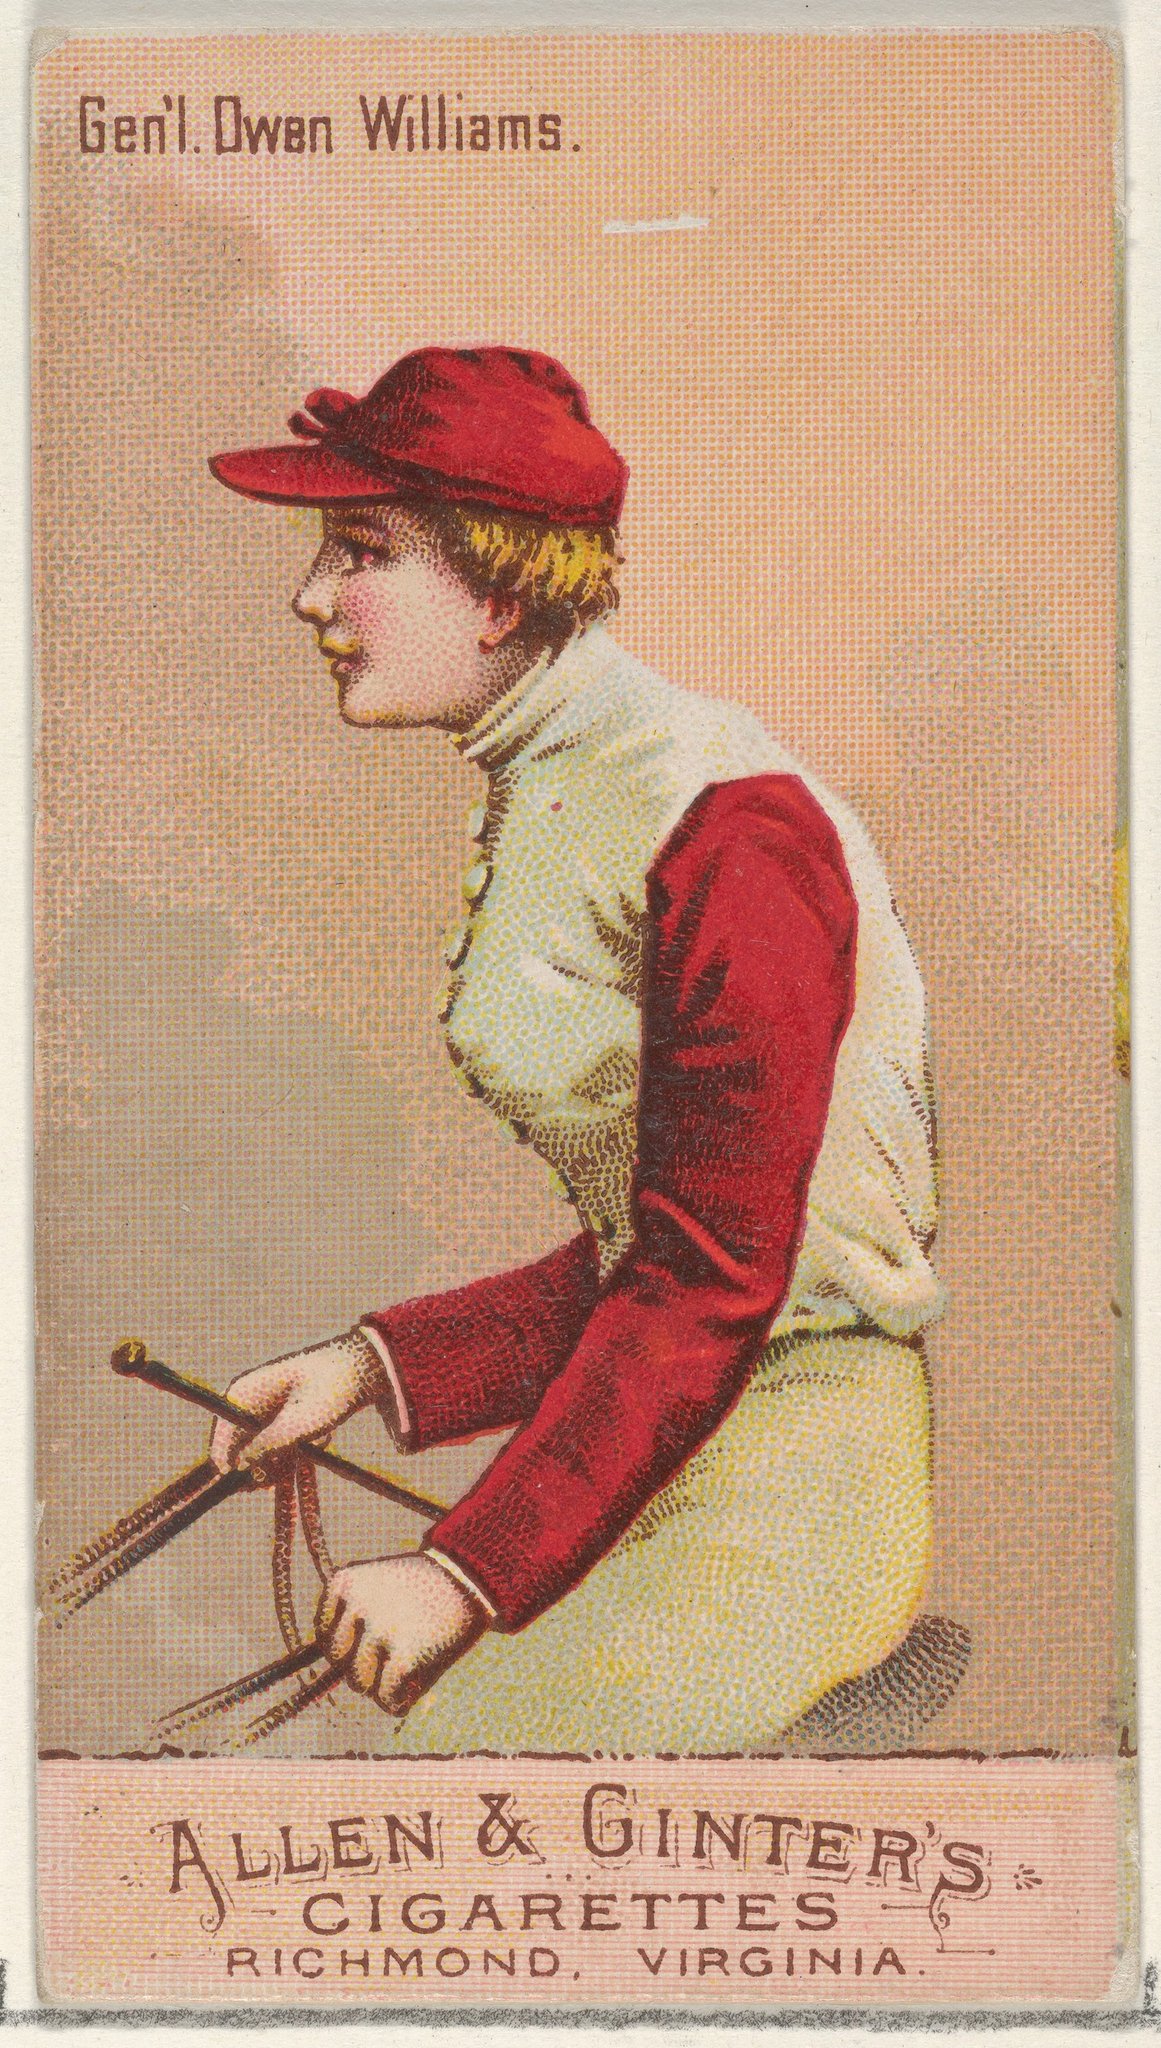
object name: print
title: General Owen Williams, from the Racing Colors of the World series (N22b) for Allen & Ginter Cigarettes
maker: allen & ginter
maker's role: publisher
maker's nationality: american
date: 1888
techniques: color lithograph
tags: profiles,women,jockeys